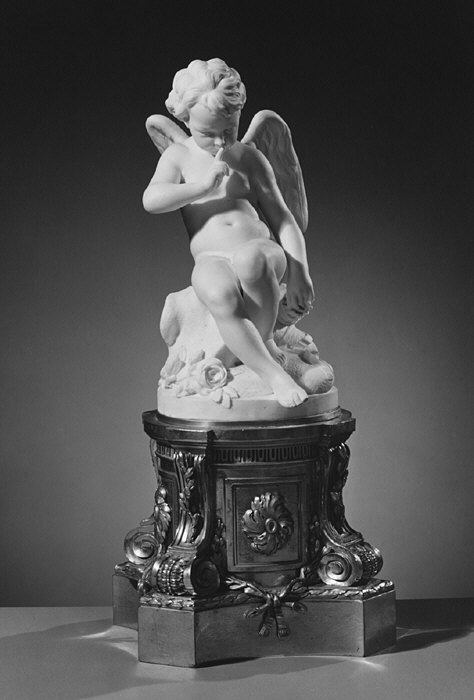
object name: figure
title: Cupid ("L'Amour Menaçant")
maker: sèvres manufactory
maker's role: manufactory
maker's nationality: french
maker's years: 1740-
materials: biscuit, gilt bronze, paste, porcelain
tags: cupid